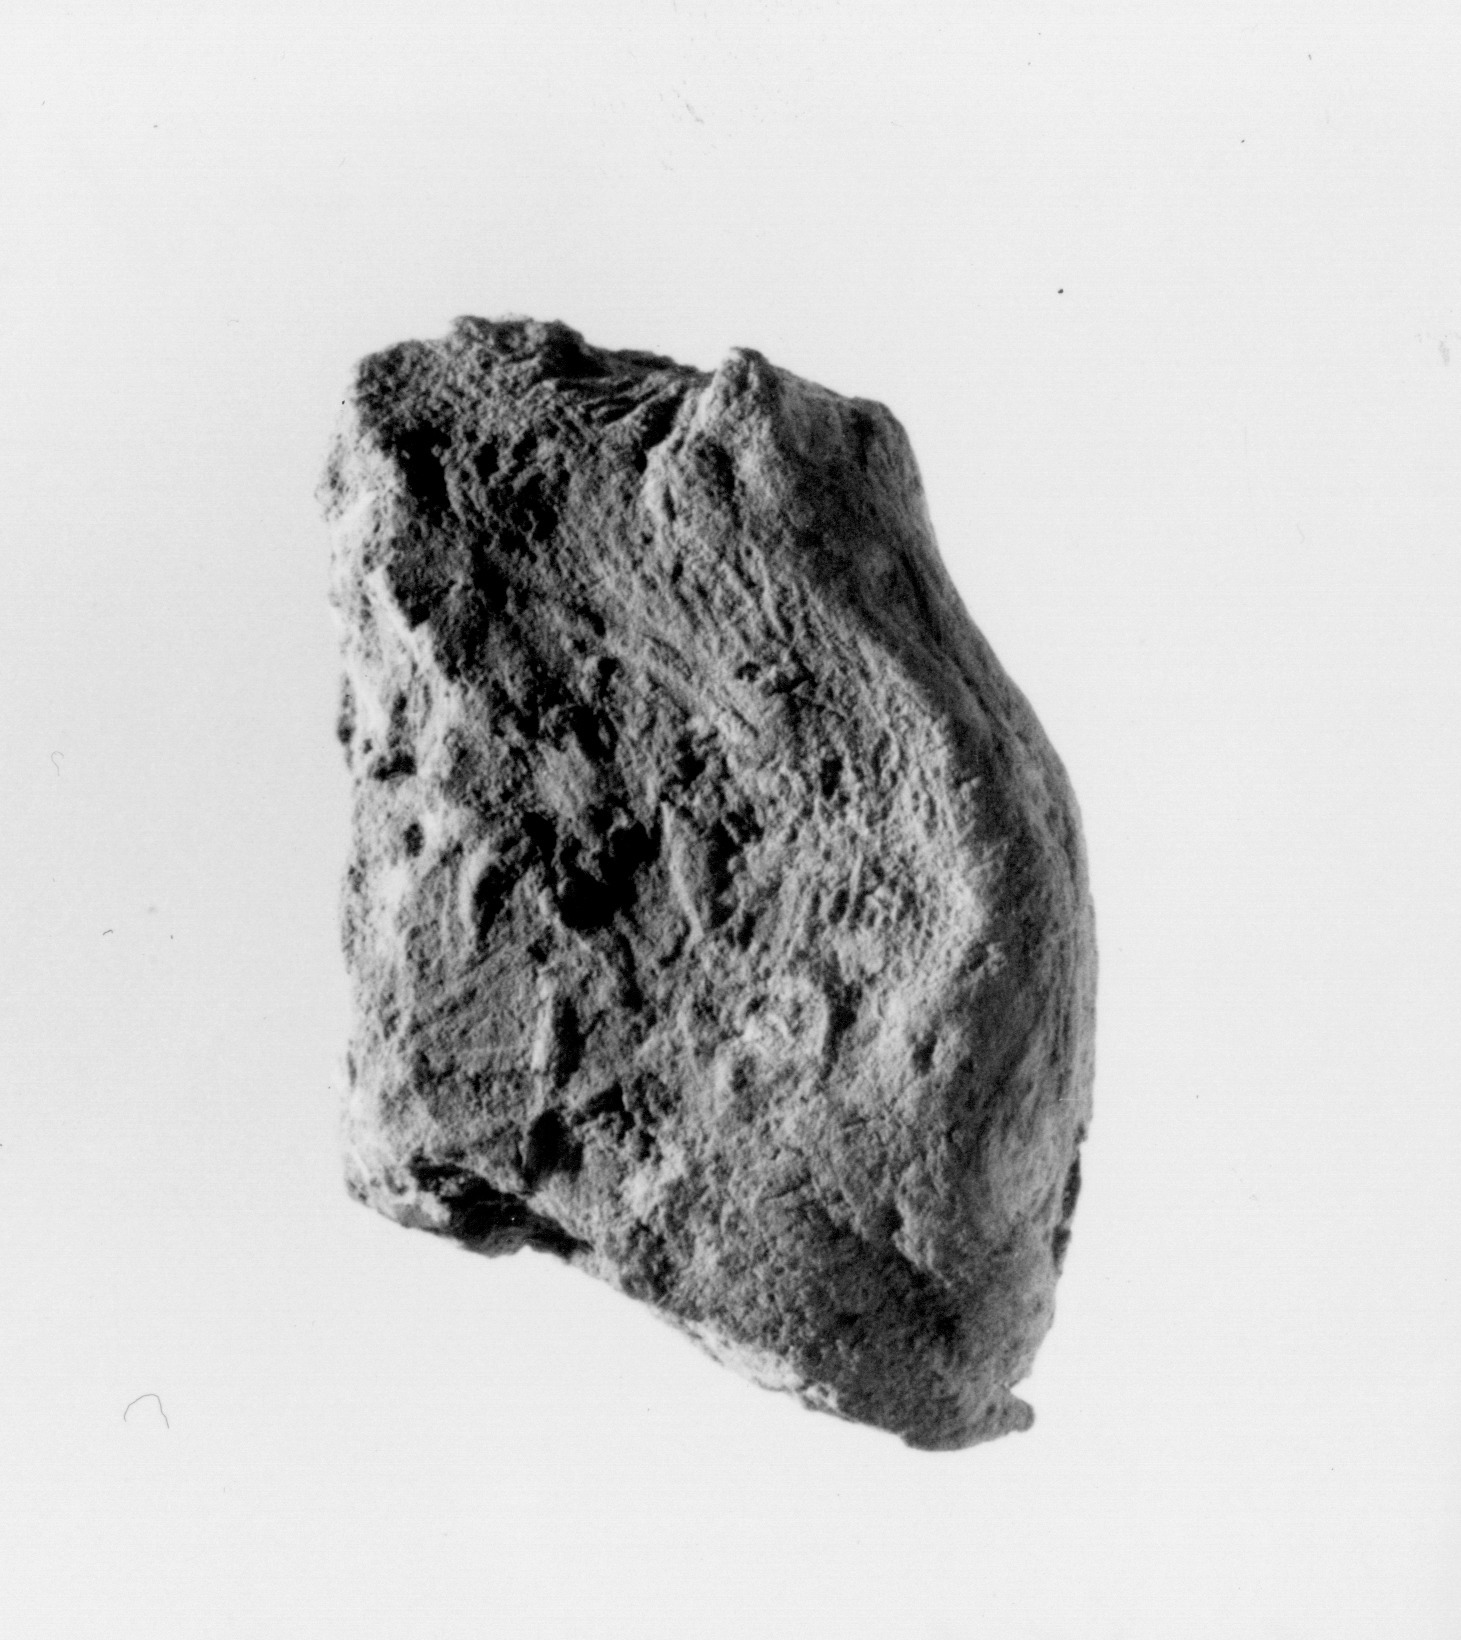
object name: sealing, bull, falcon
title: Document Sealing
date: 1390-1352 BCE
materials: mud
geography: egypt